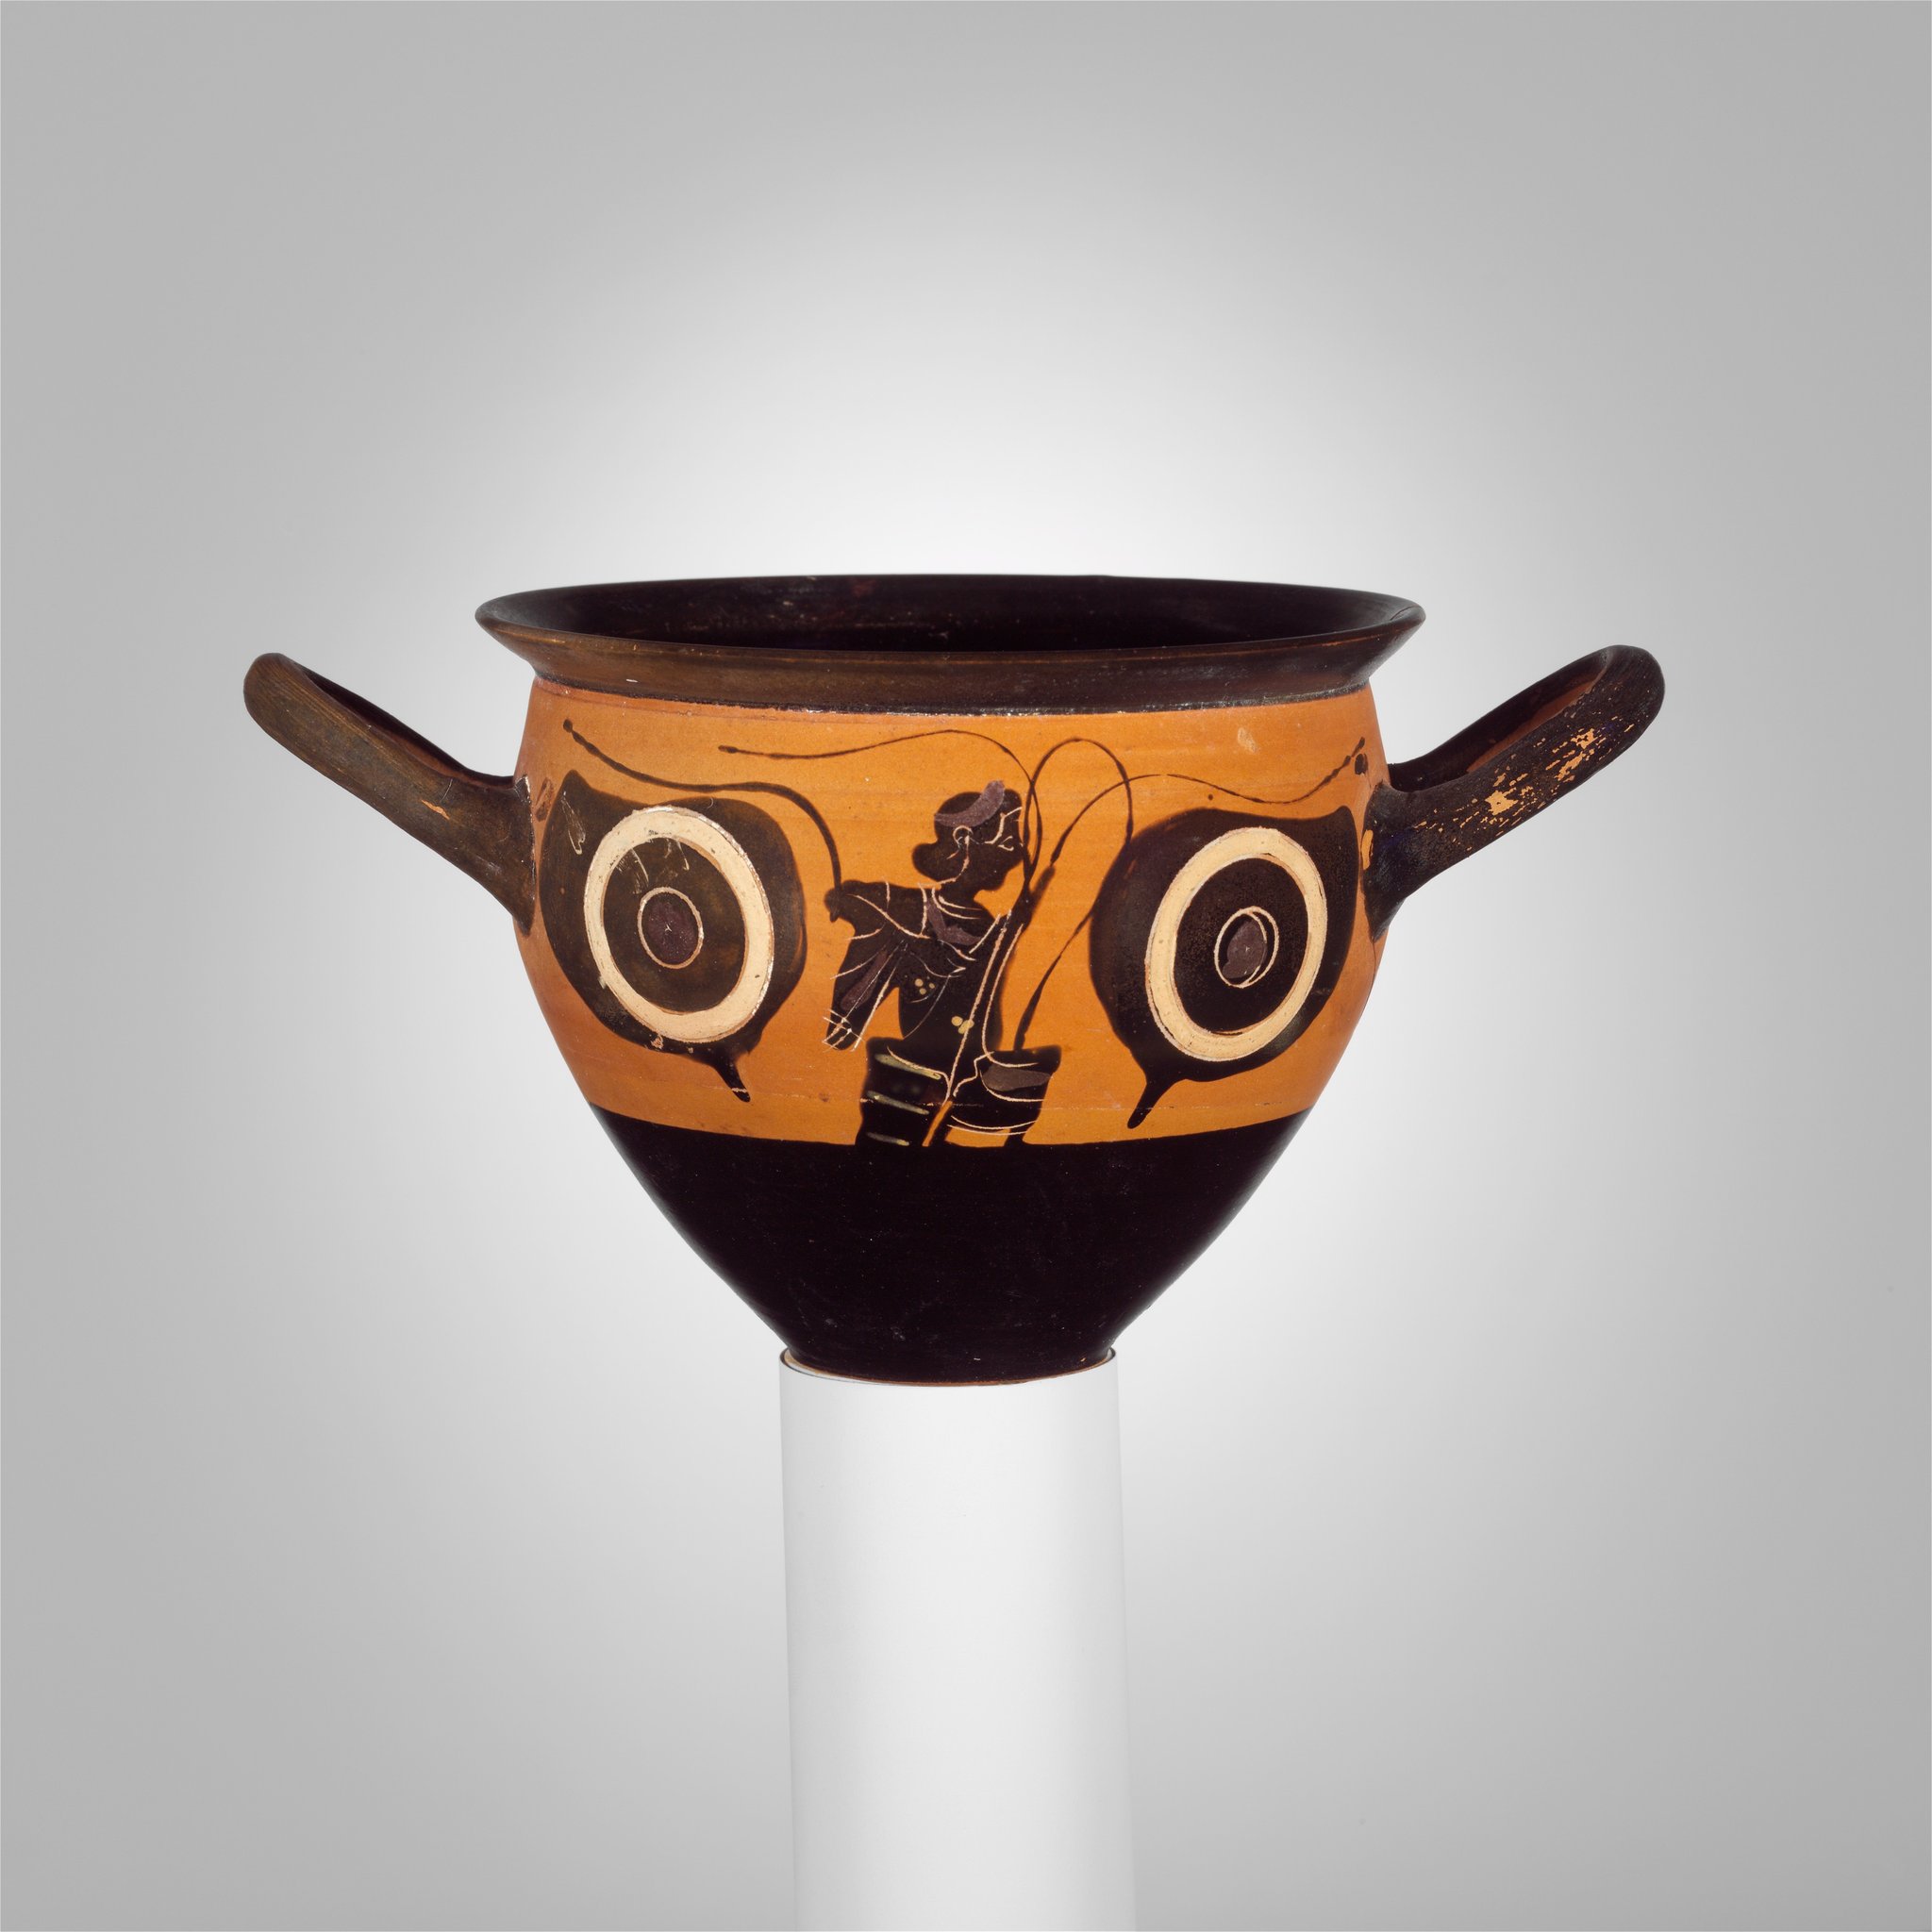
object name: mastoid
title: Terracotta mastoid (drinking cup with narrow base)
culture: greek, attic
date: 500 BCE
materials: terracotta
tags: eyes,men